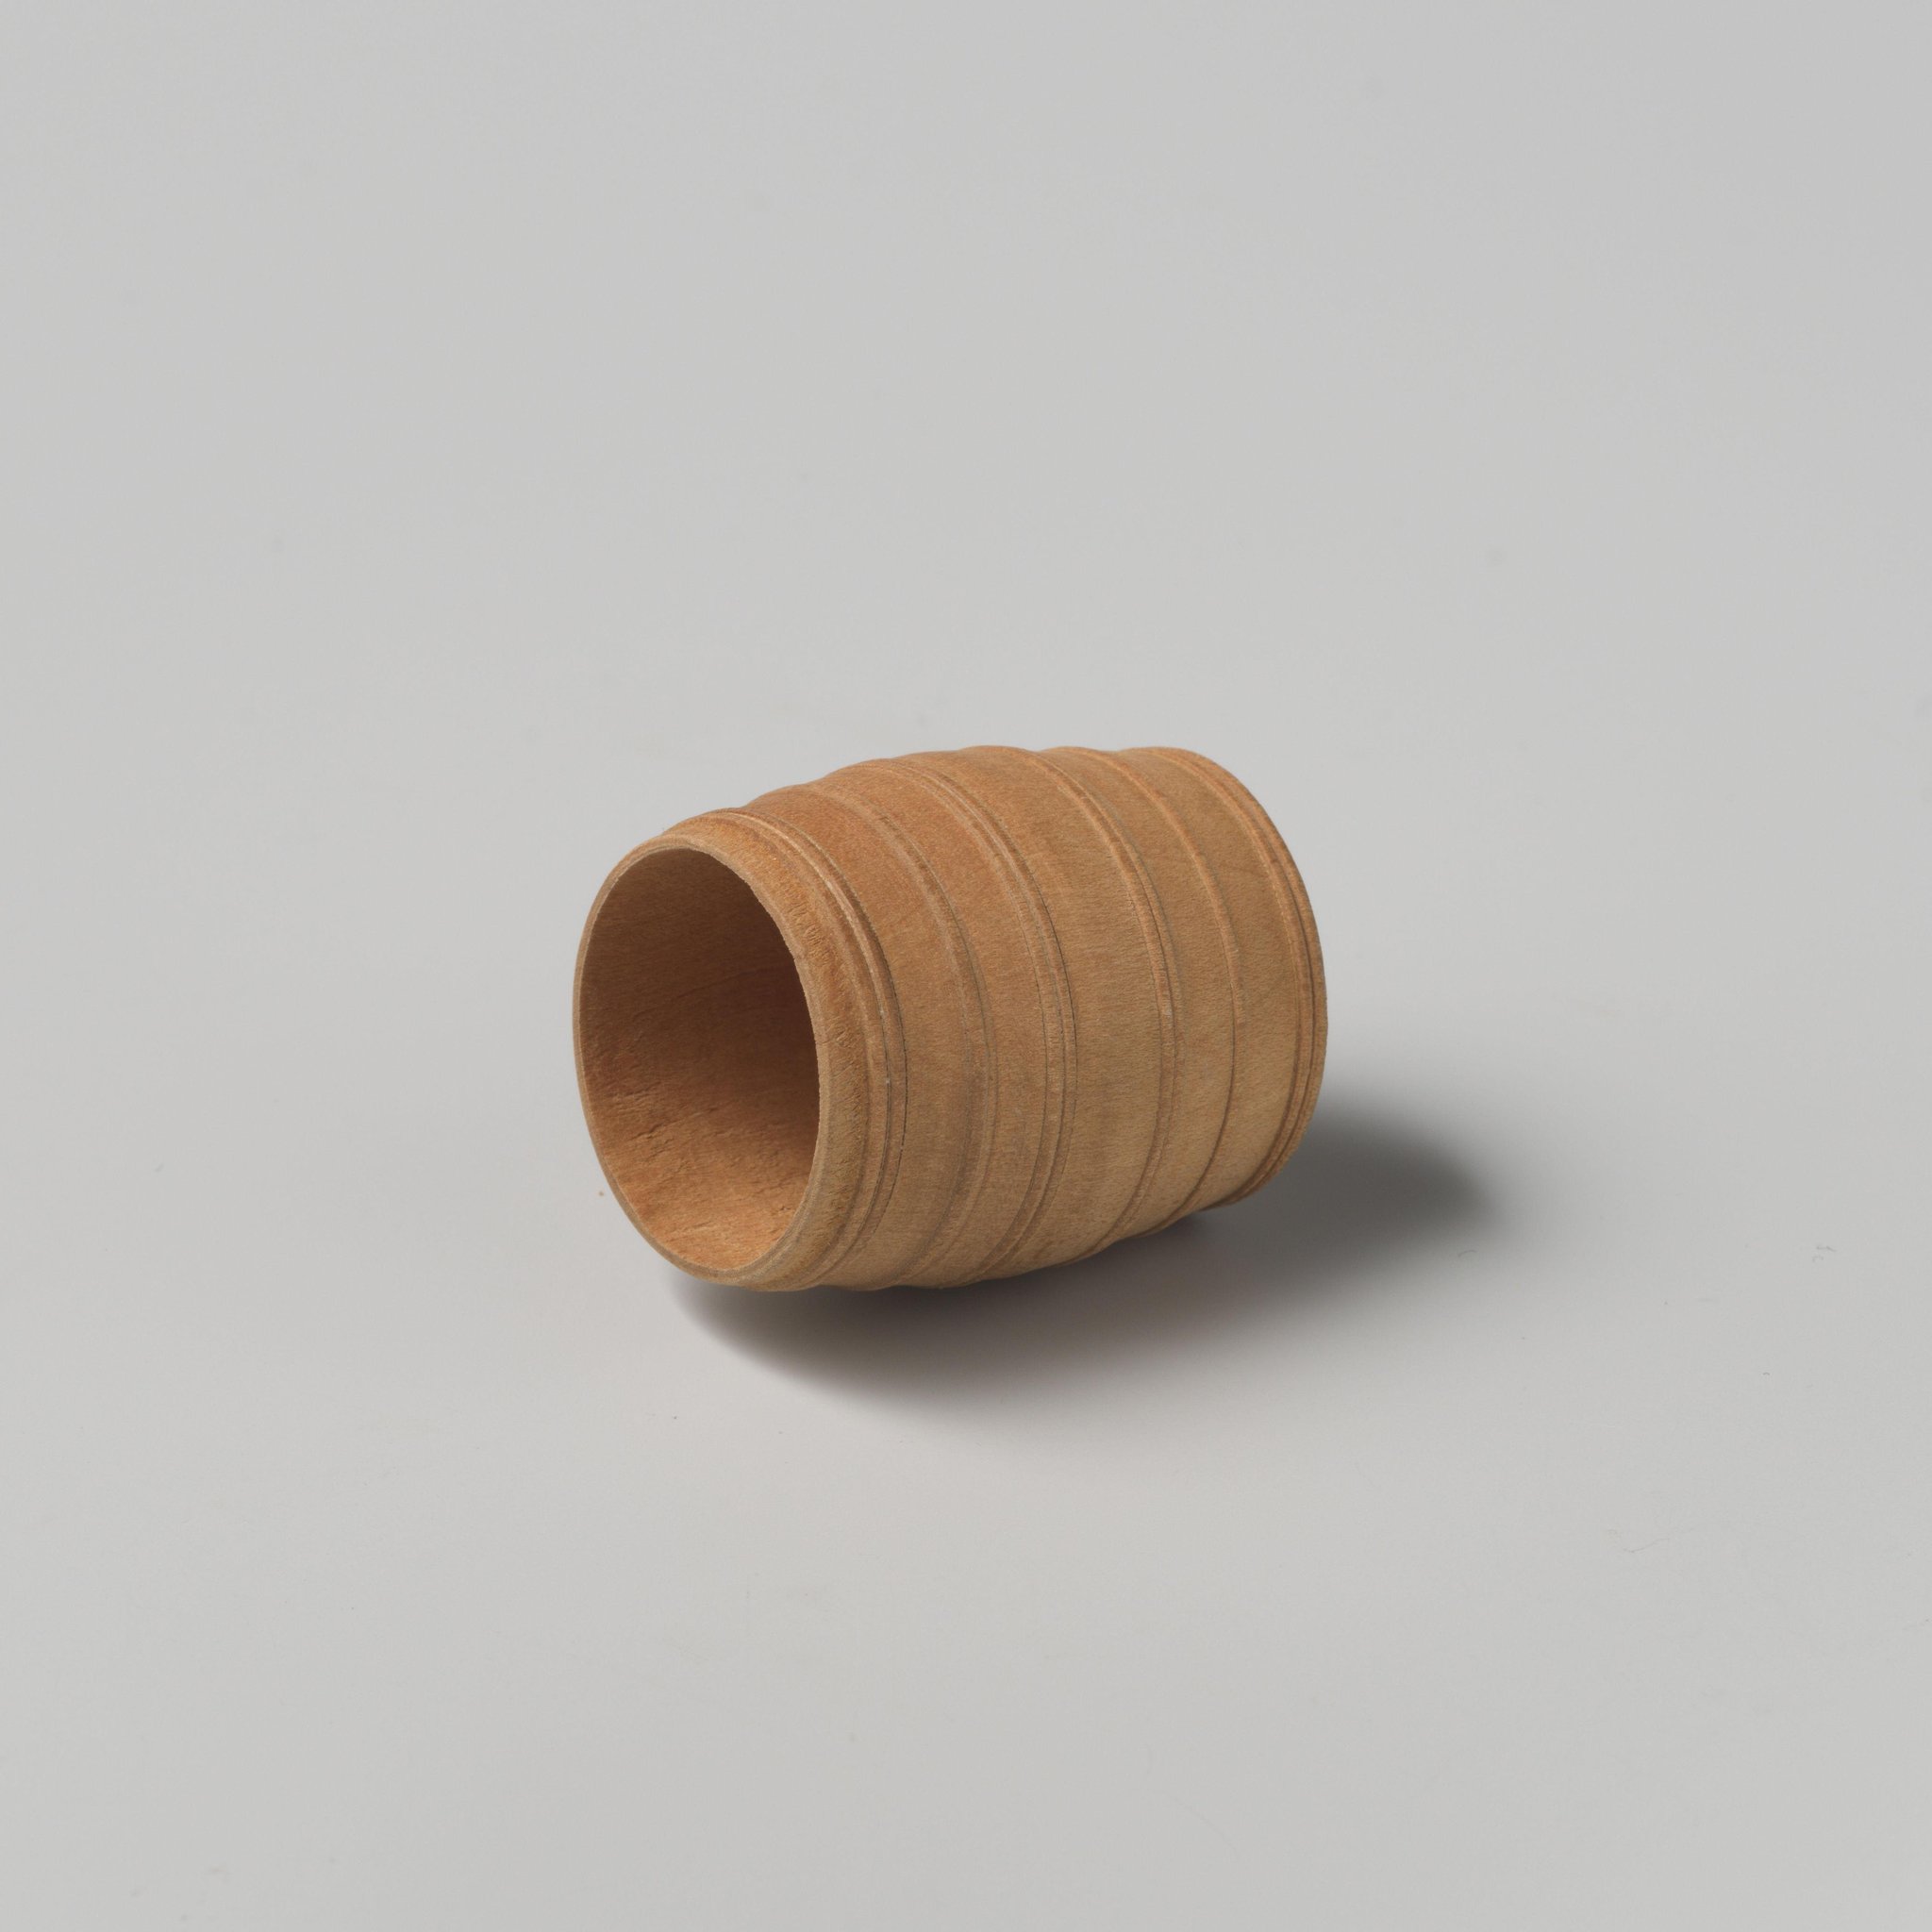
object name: miniature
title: Vat of ton, gedraaid van esdoornhout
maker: Anonymous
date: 1676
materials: iron, wood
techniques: turning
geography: amsterdam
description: Vat of ton, gedraaid van esdoornhout met ringen, de hoepels voorstellende. In het vat worden nagels van smeedijzer bewaard.